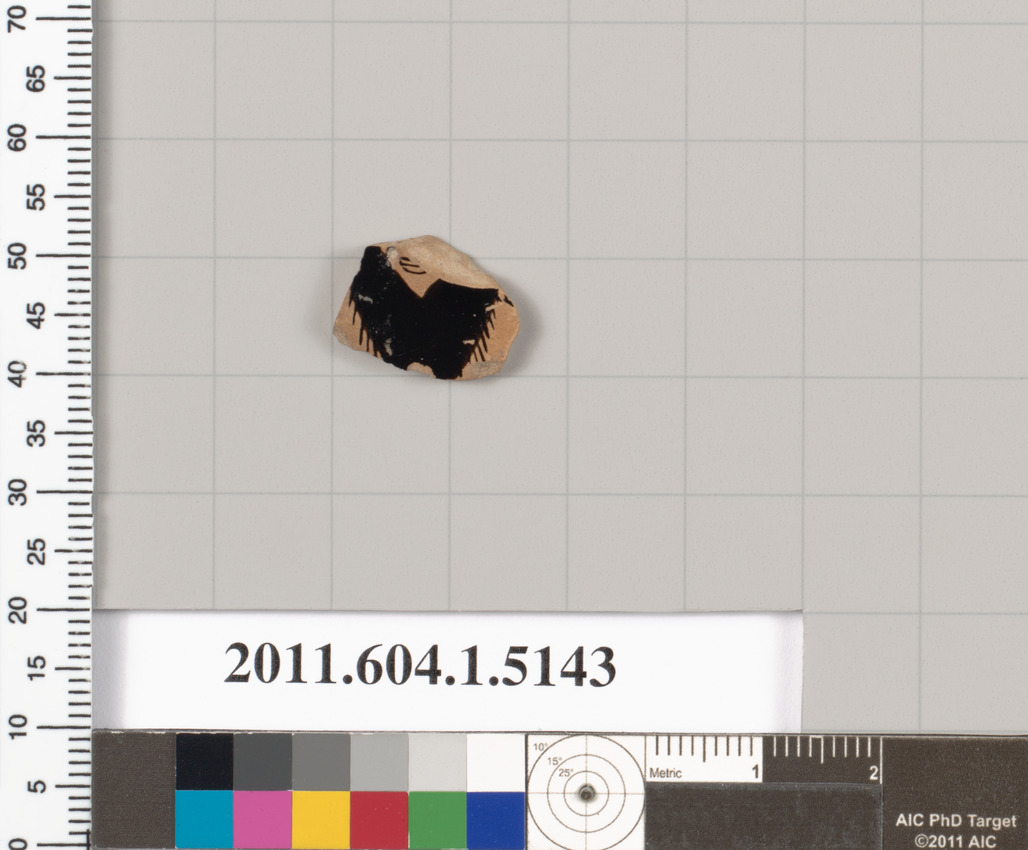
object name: kylix fragment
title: Terracotta fragment of a kylix (drinking cup)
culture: greek, attic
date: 500-480 BCE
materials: terracotta